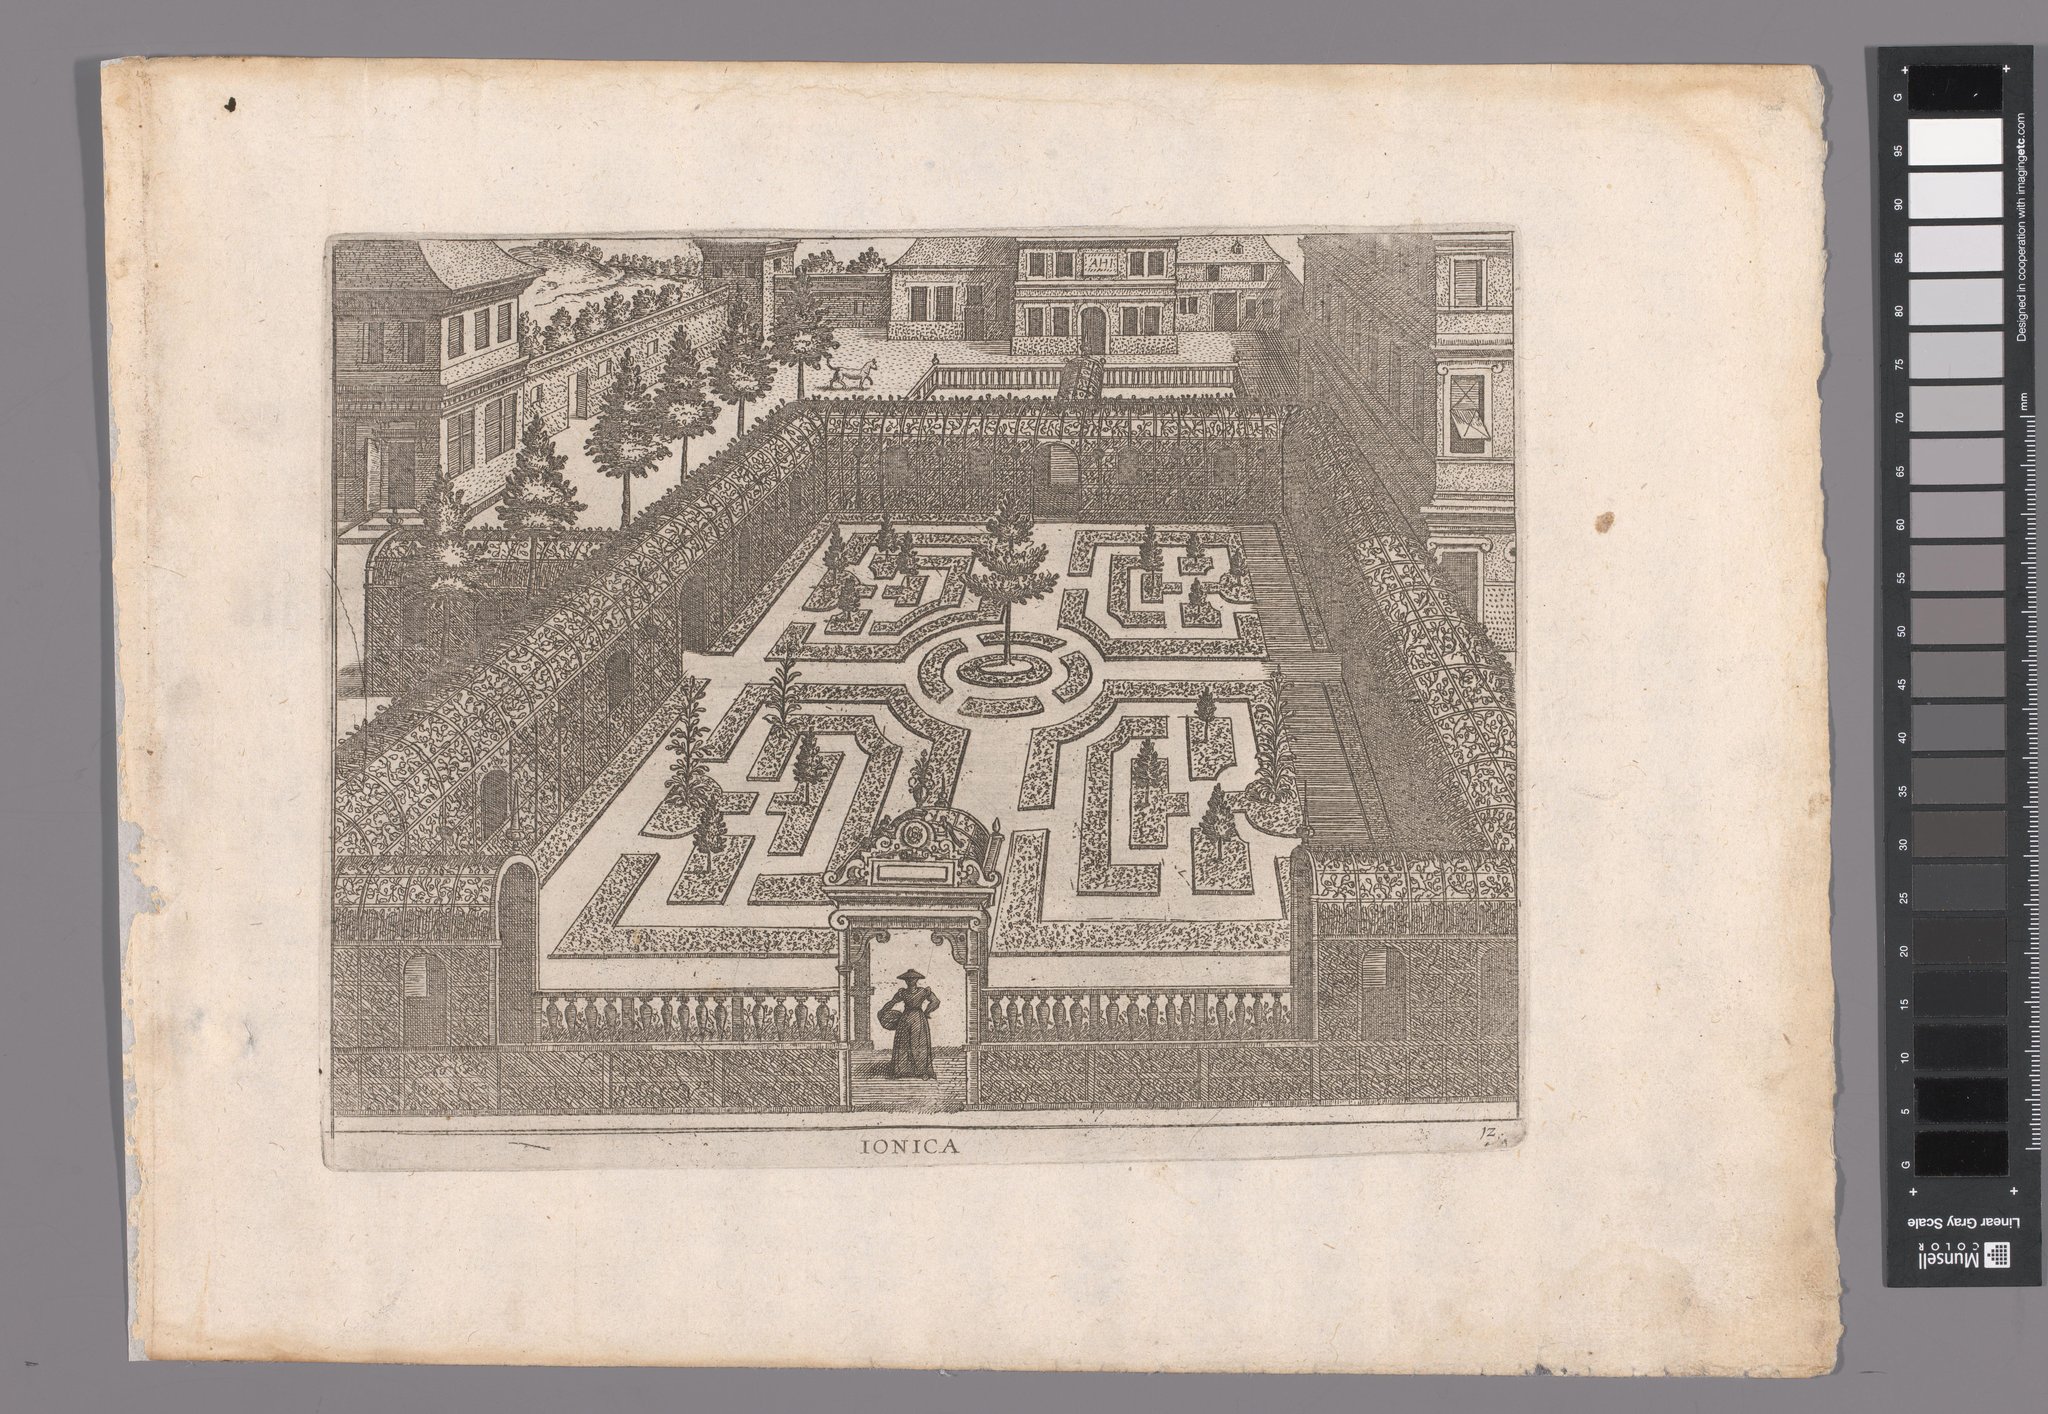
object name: print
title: Tuin met een parterre omsloten door een gang van traliewerk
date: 1583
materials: paper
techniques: etching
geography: antwerp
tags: garden, french or architectonic garden; formal garden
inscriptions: collector's mark: Lugt 2228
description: Tuin met een parterre omsloten door een begroeide gang van traliewerk. Op de voorgrond in het midden staat een vrouw in de poort. De tuin is aangelegd volgens de Ionische bouworde.